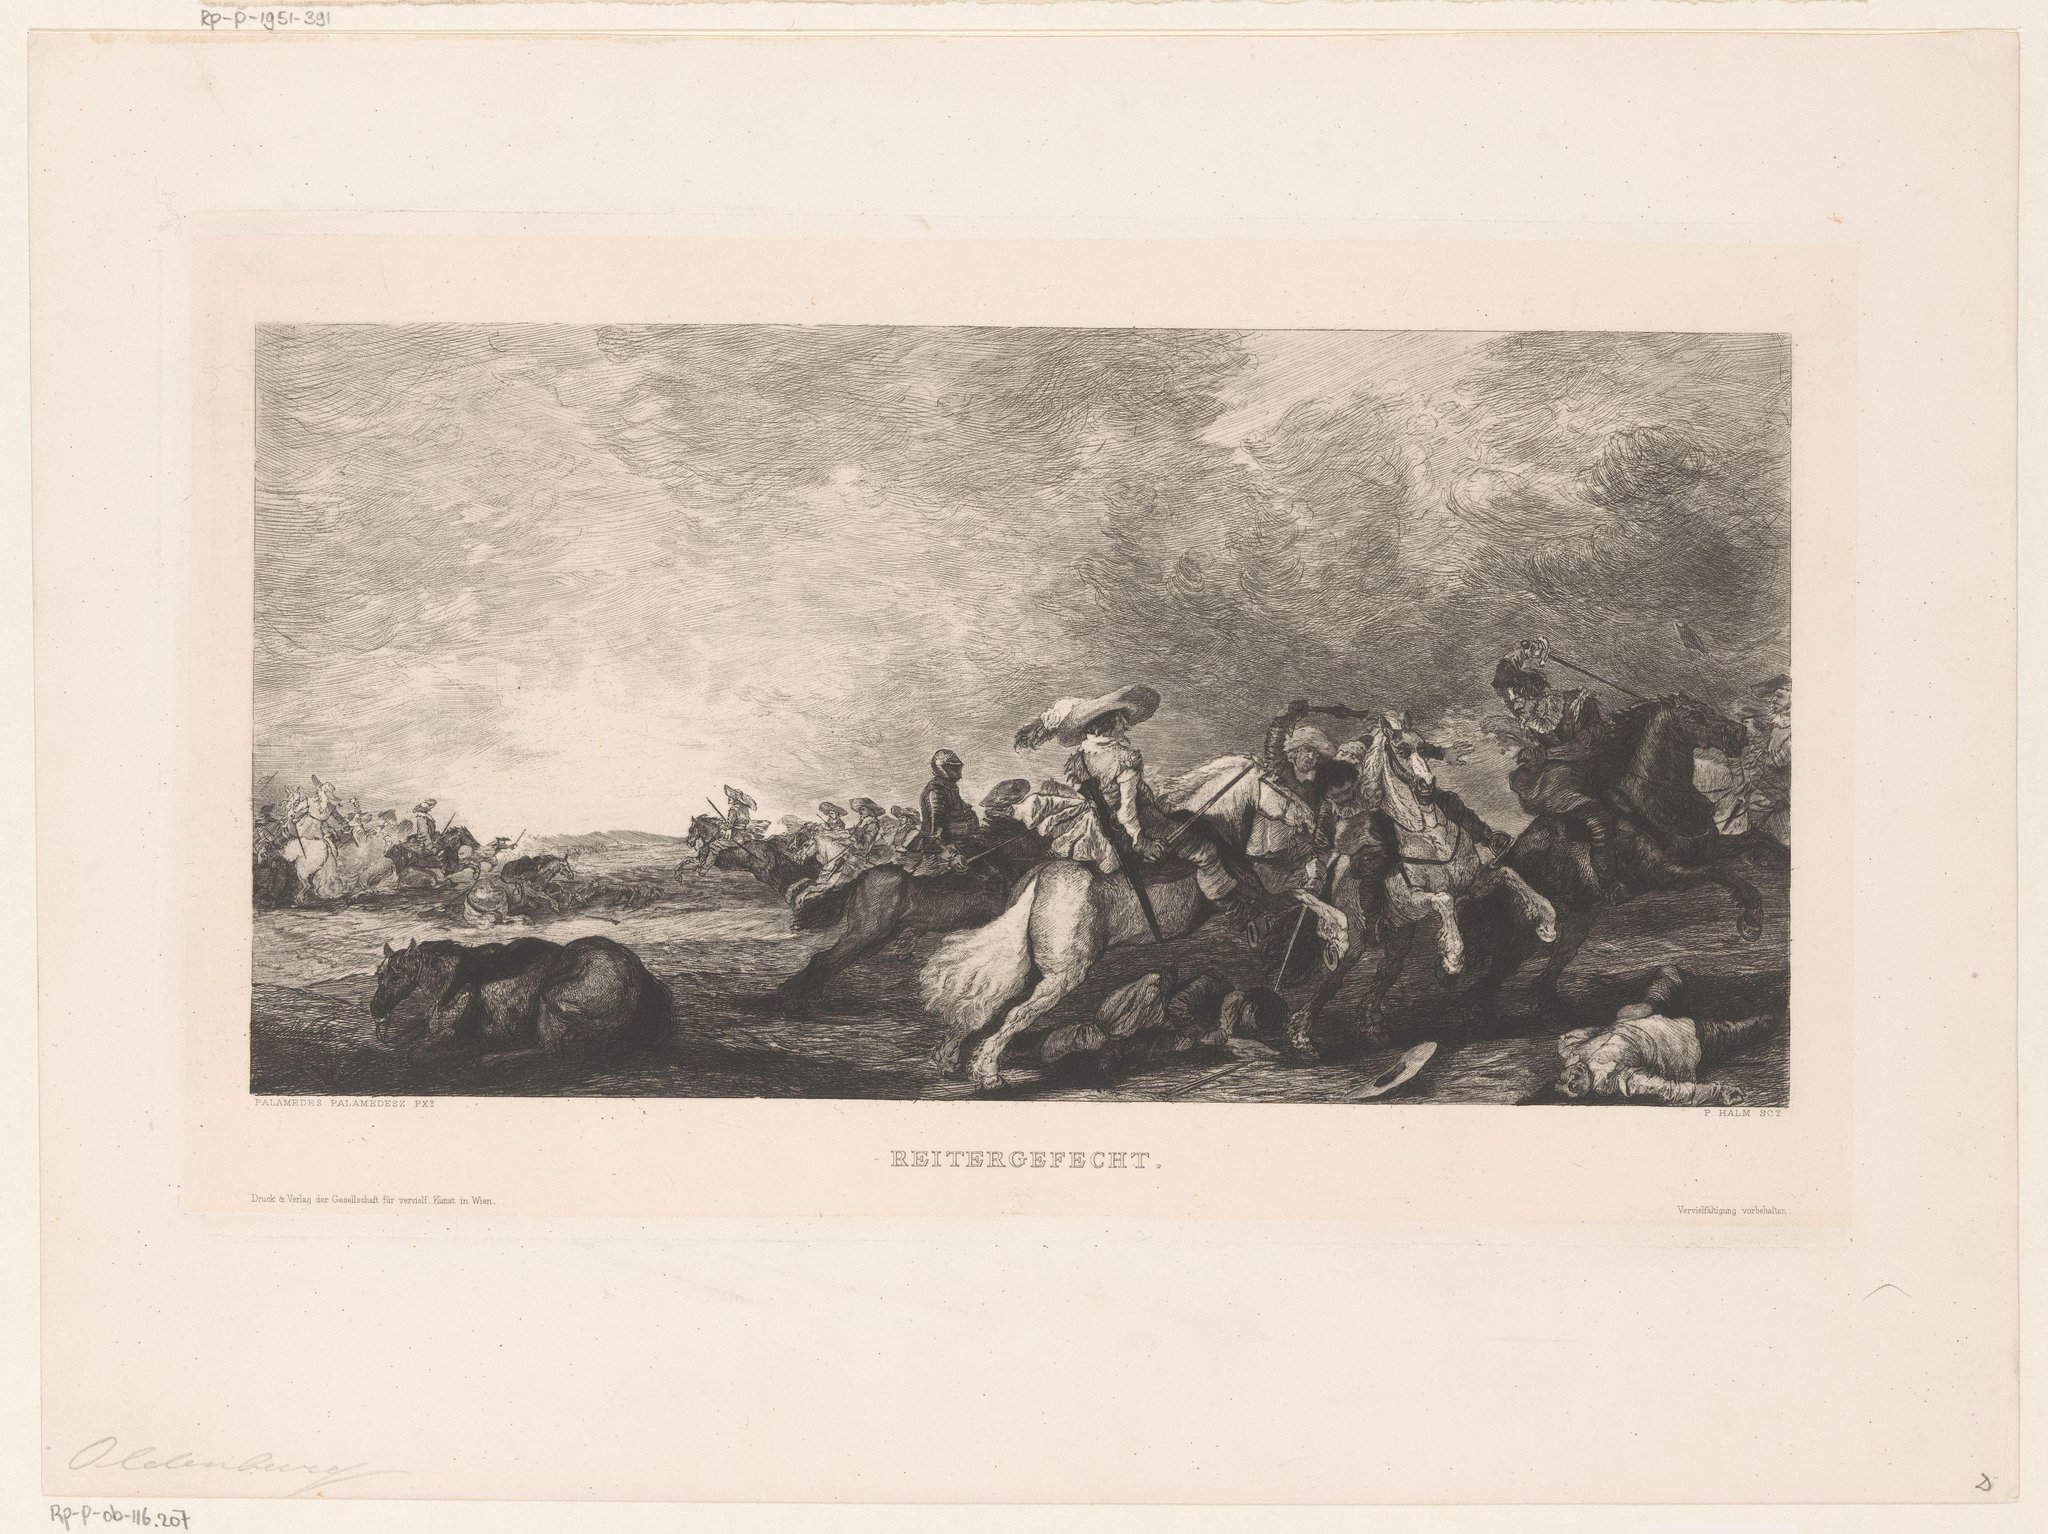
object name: print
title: Reitergefecht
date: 1864-1923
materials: paper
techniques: drypoint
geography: vienna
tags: riding a horse, ass, or mule; rider, horseman, charge ~ battle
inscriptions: collector's mark: Lugt 2228